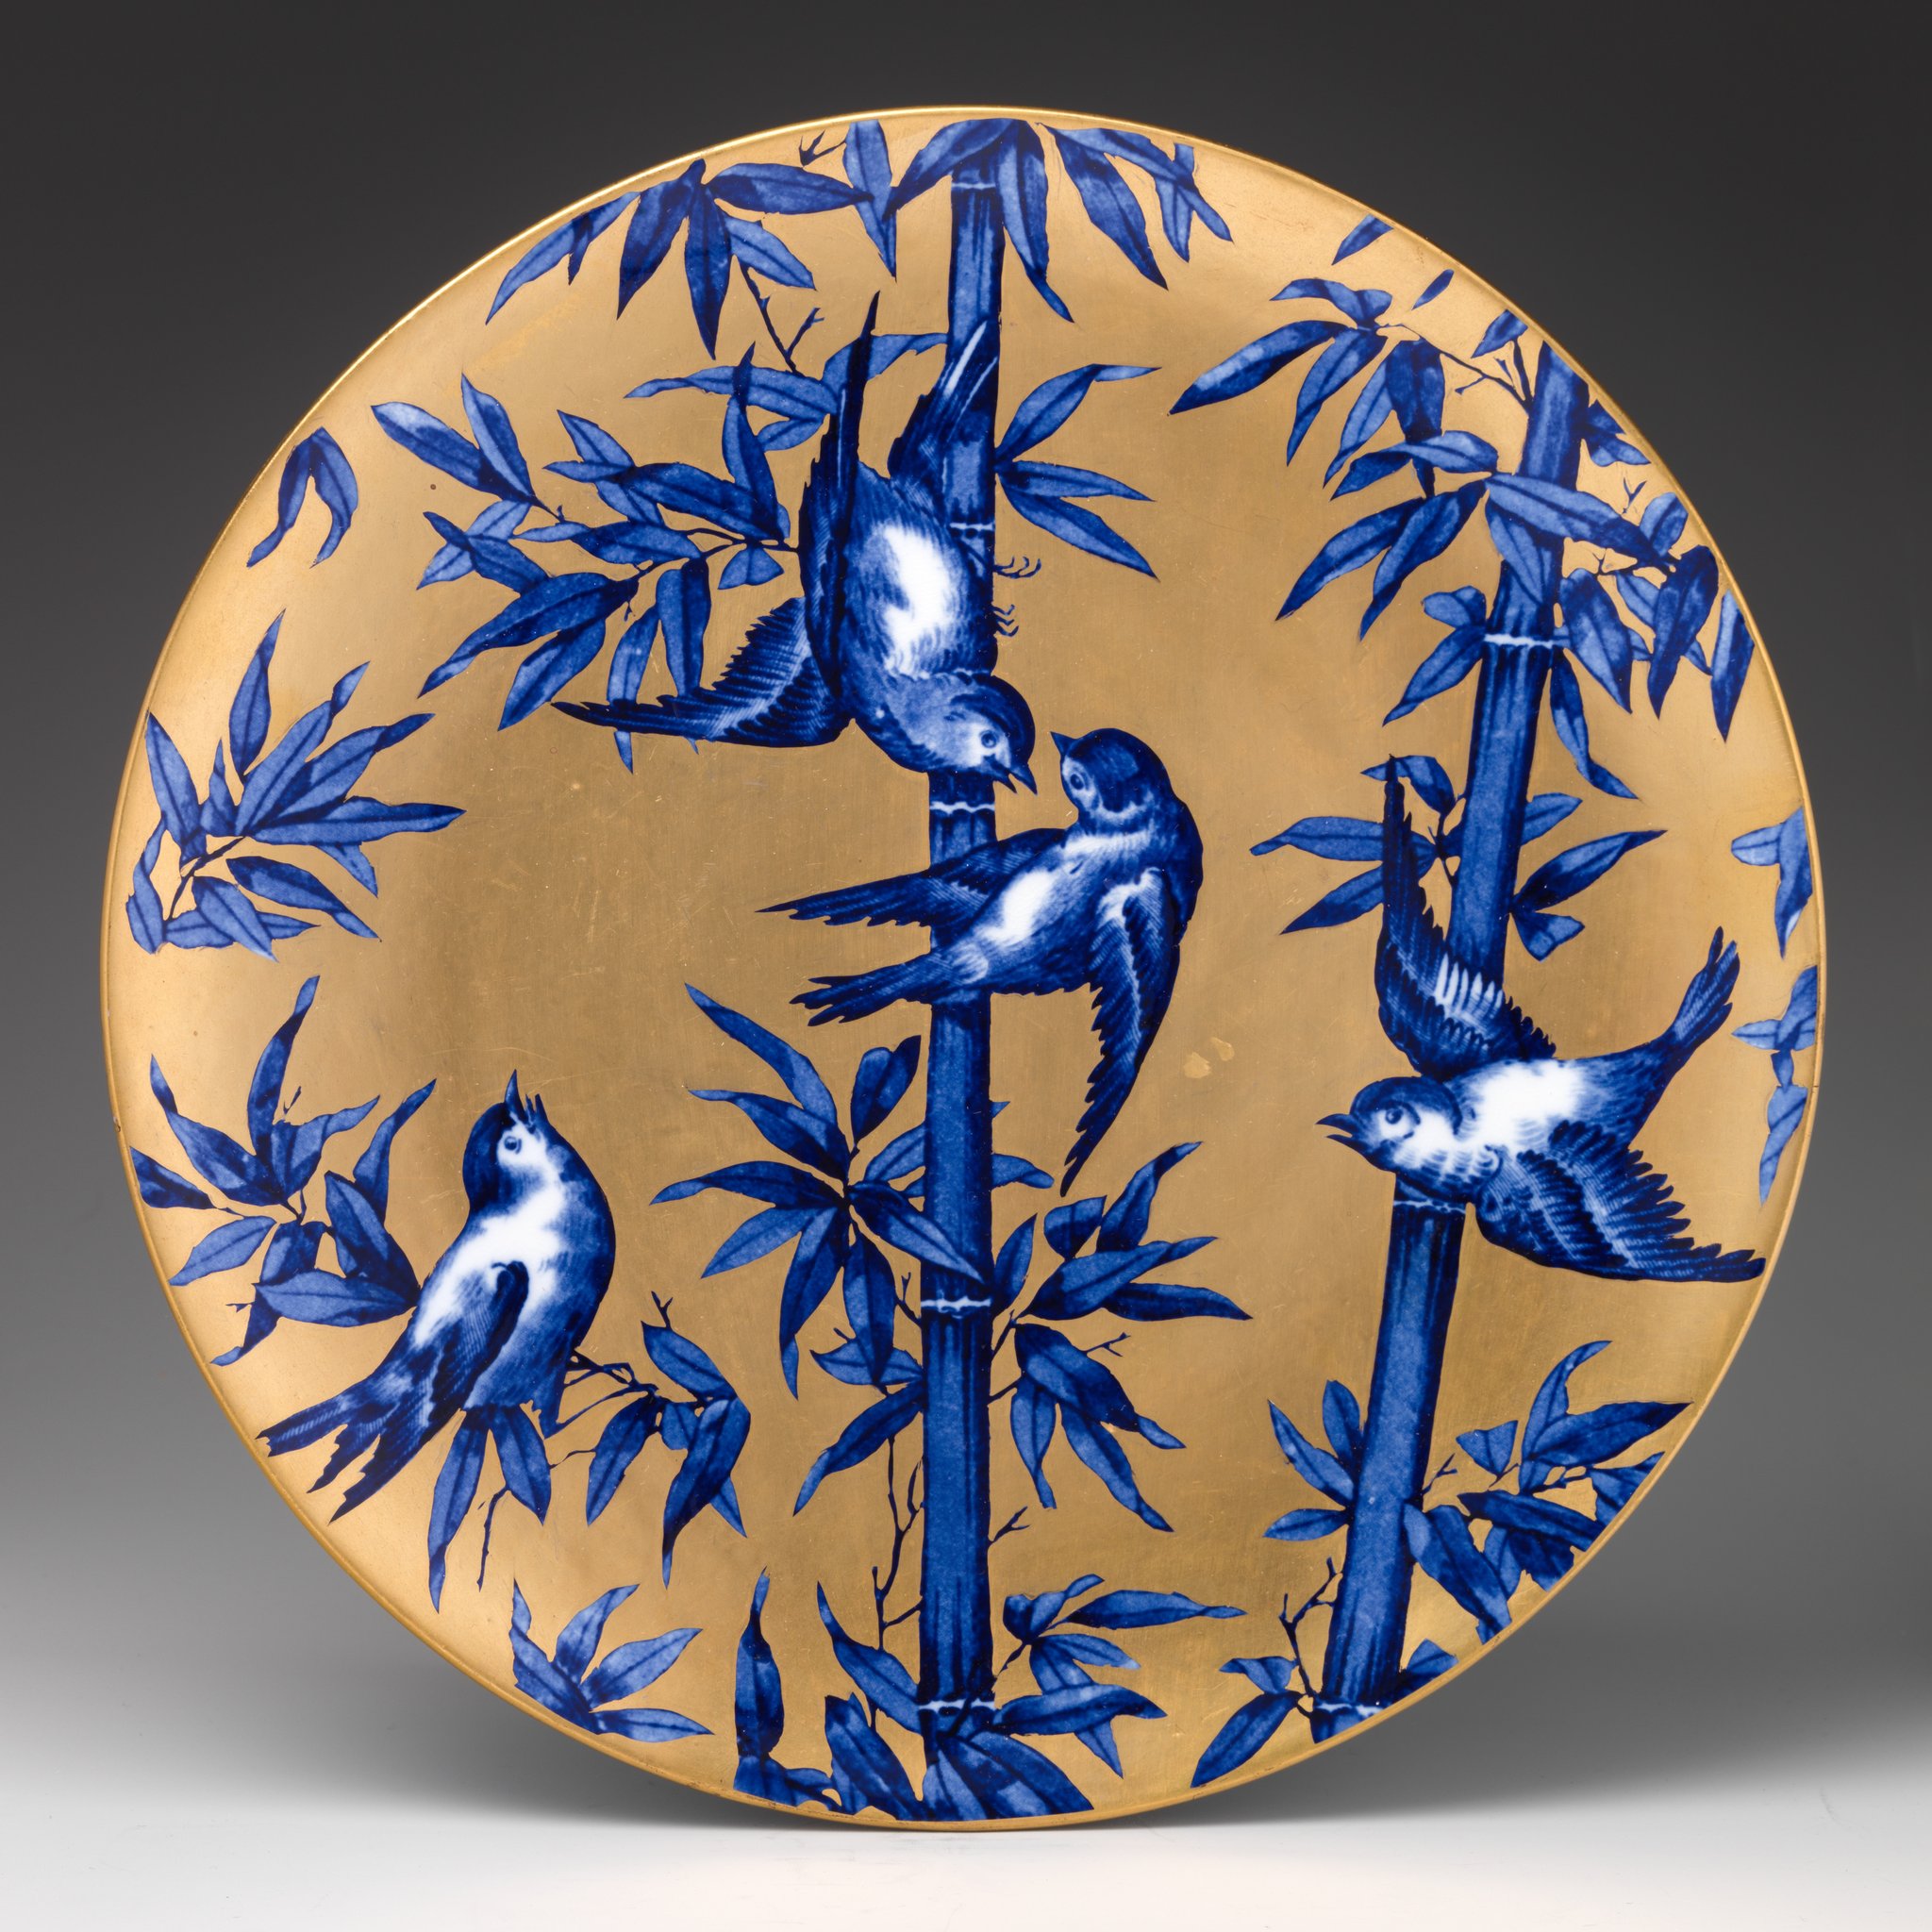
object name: plate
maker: coalport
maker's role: maker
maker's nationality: british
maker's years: 1794-1926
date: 1881-1891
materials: porcelain